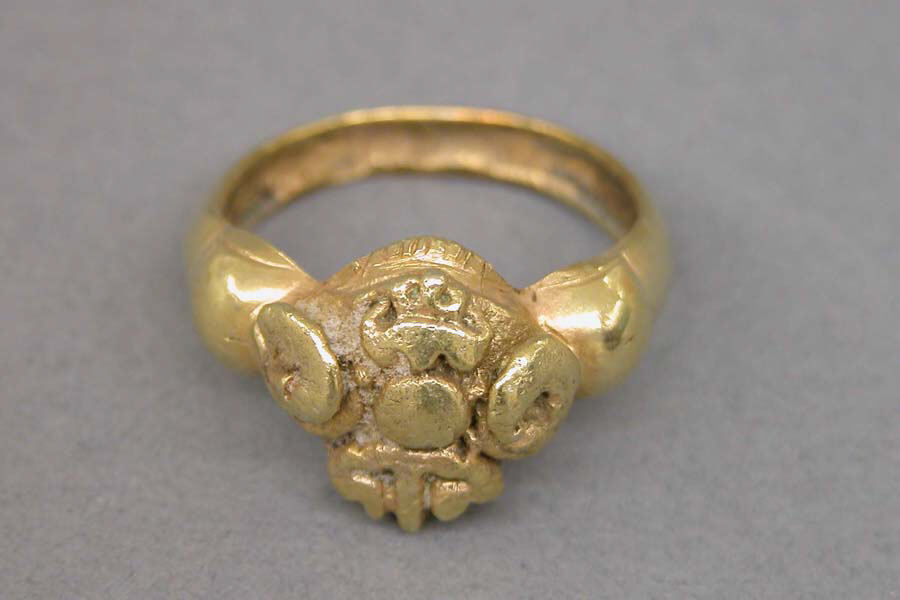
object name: ring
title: Ring with Stylized Ram's Head on Bezel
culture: indonesian, javanese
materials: gold